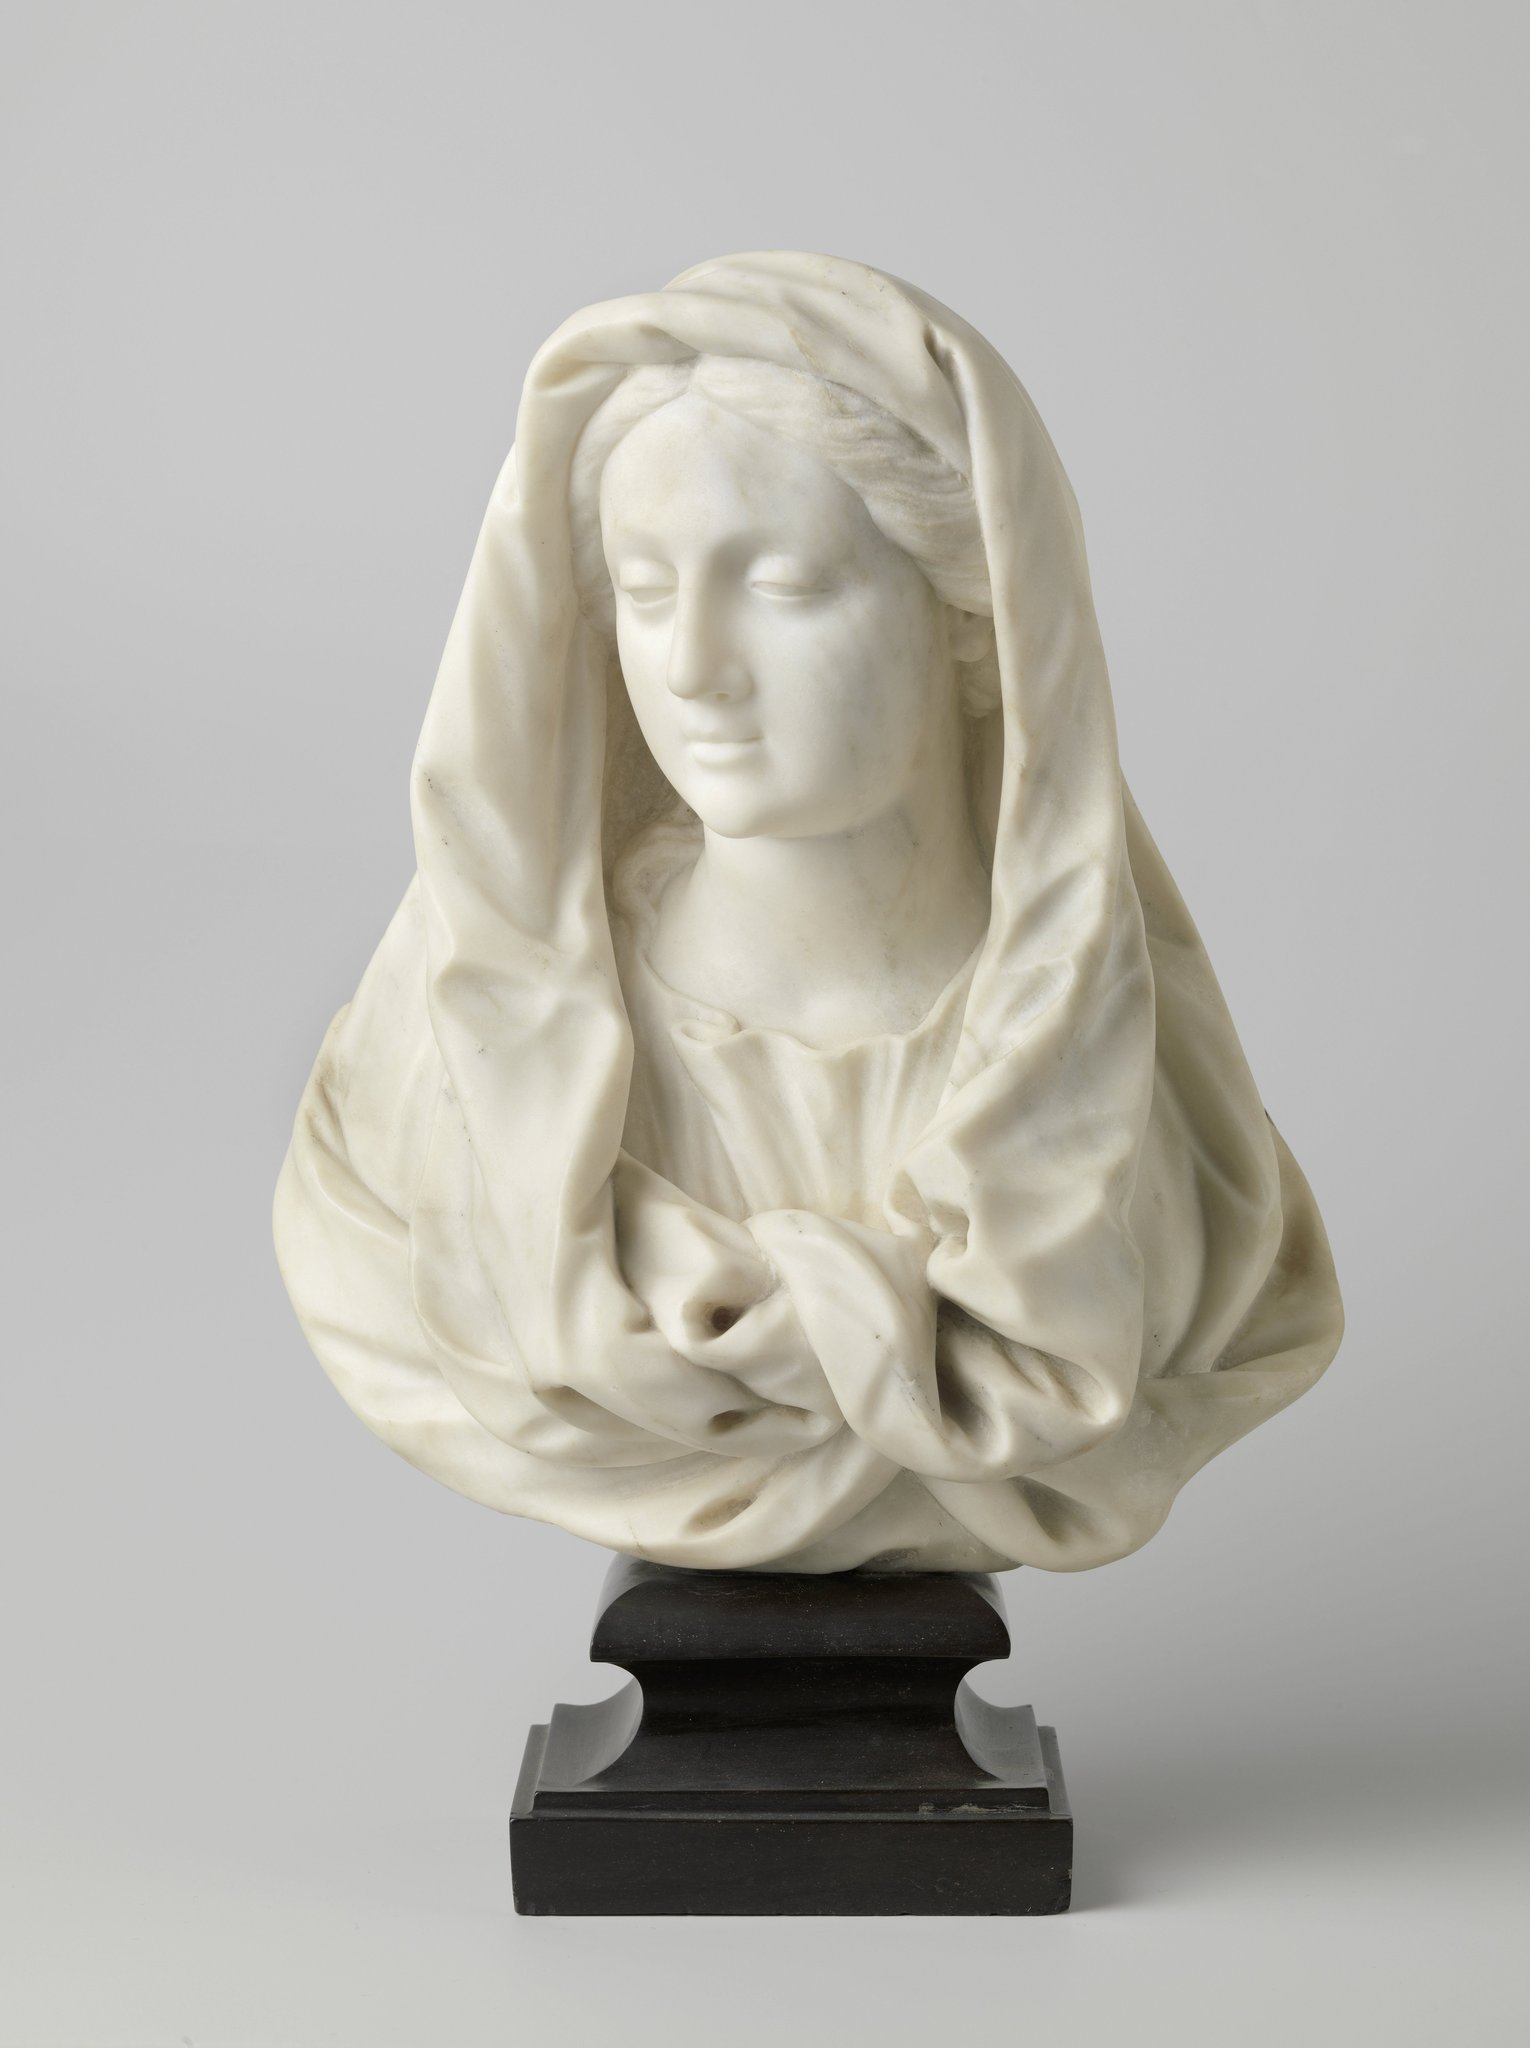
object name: sculpture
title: Borstbeeld van Maria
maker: Anonymous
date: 1700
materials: marble